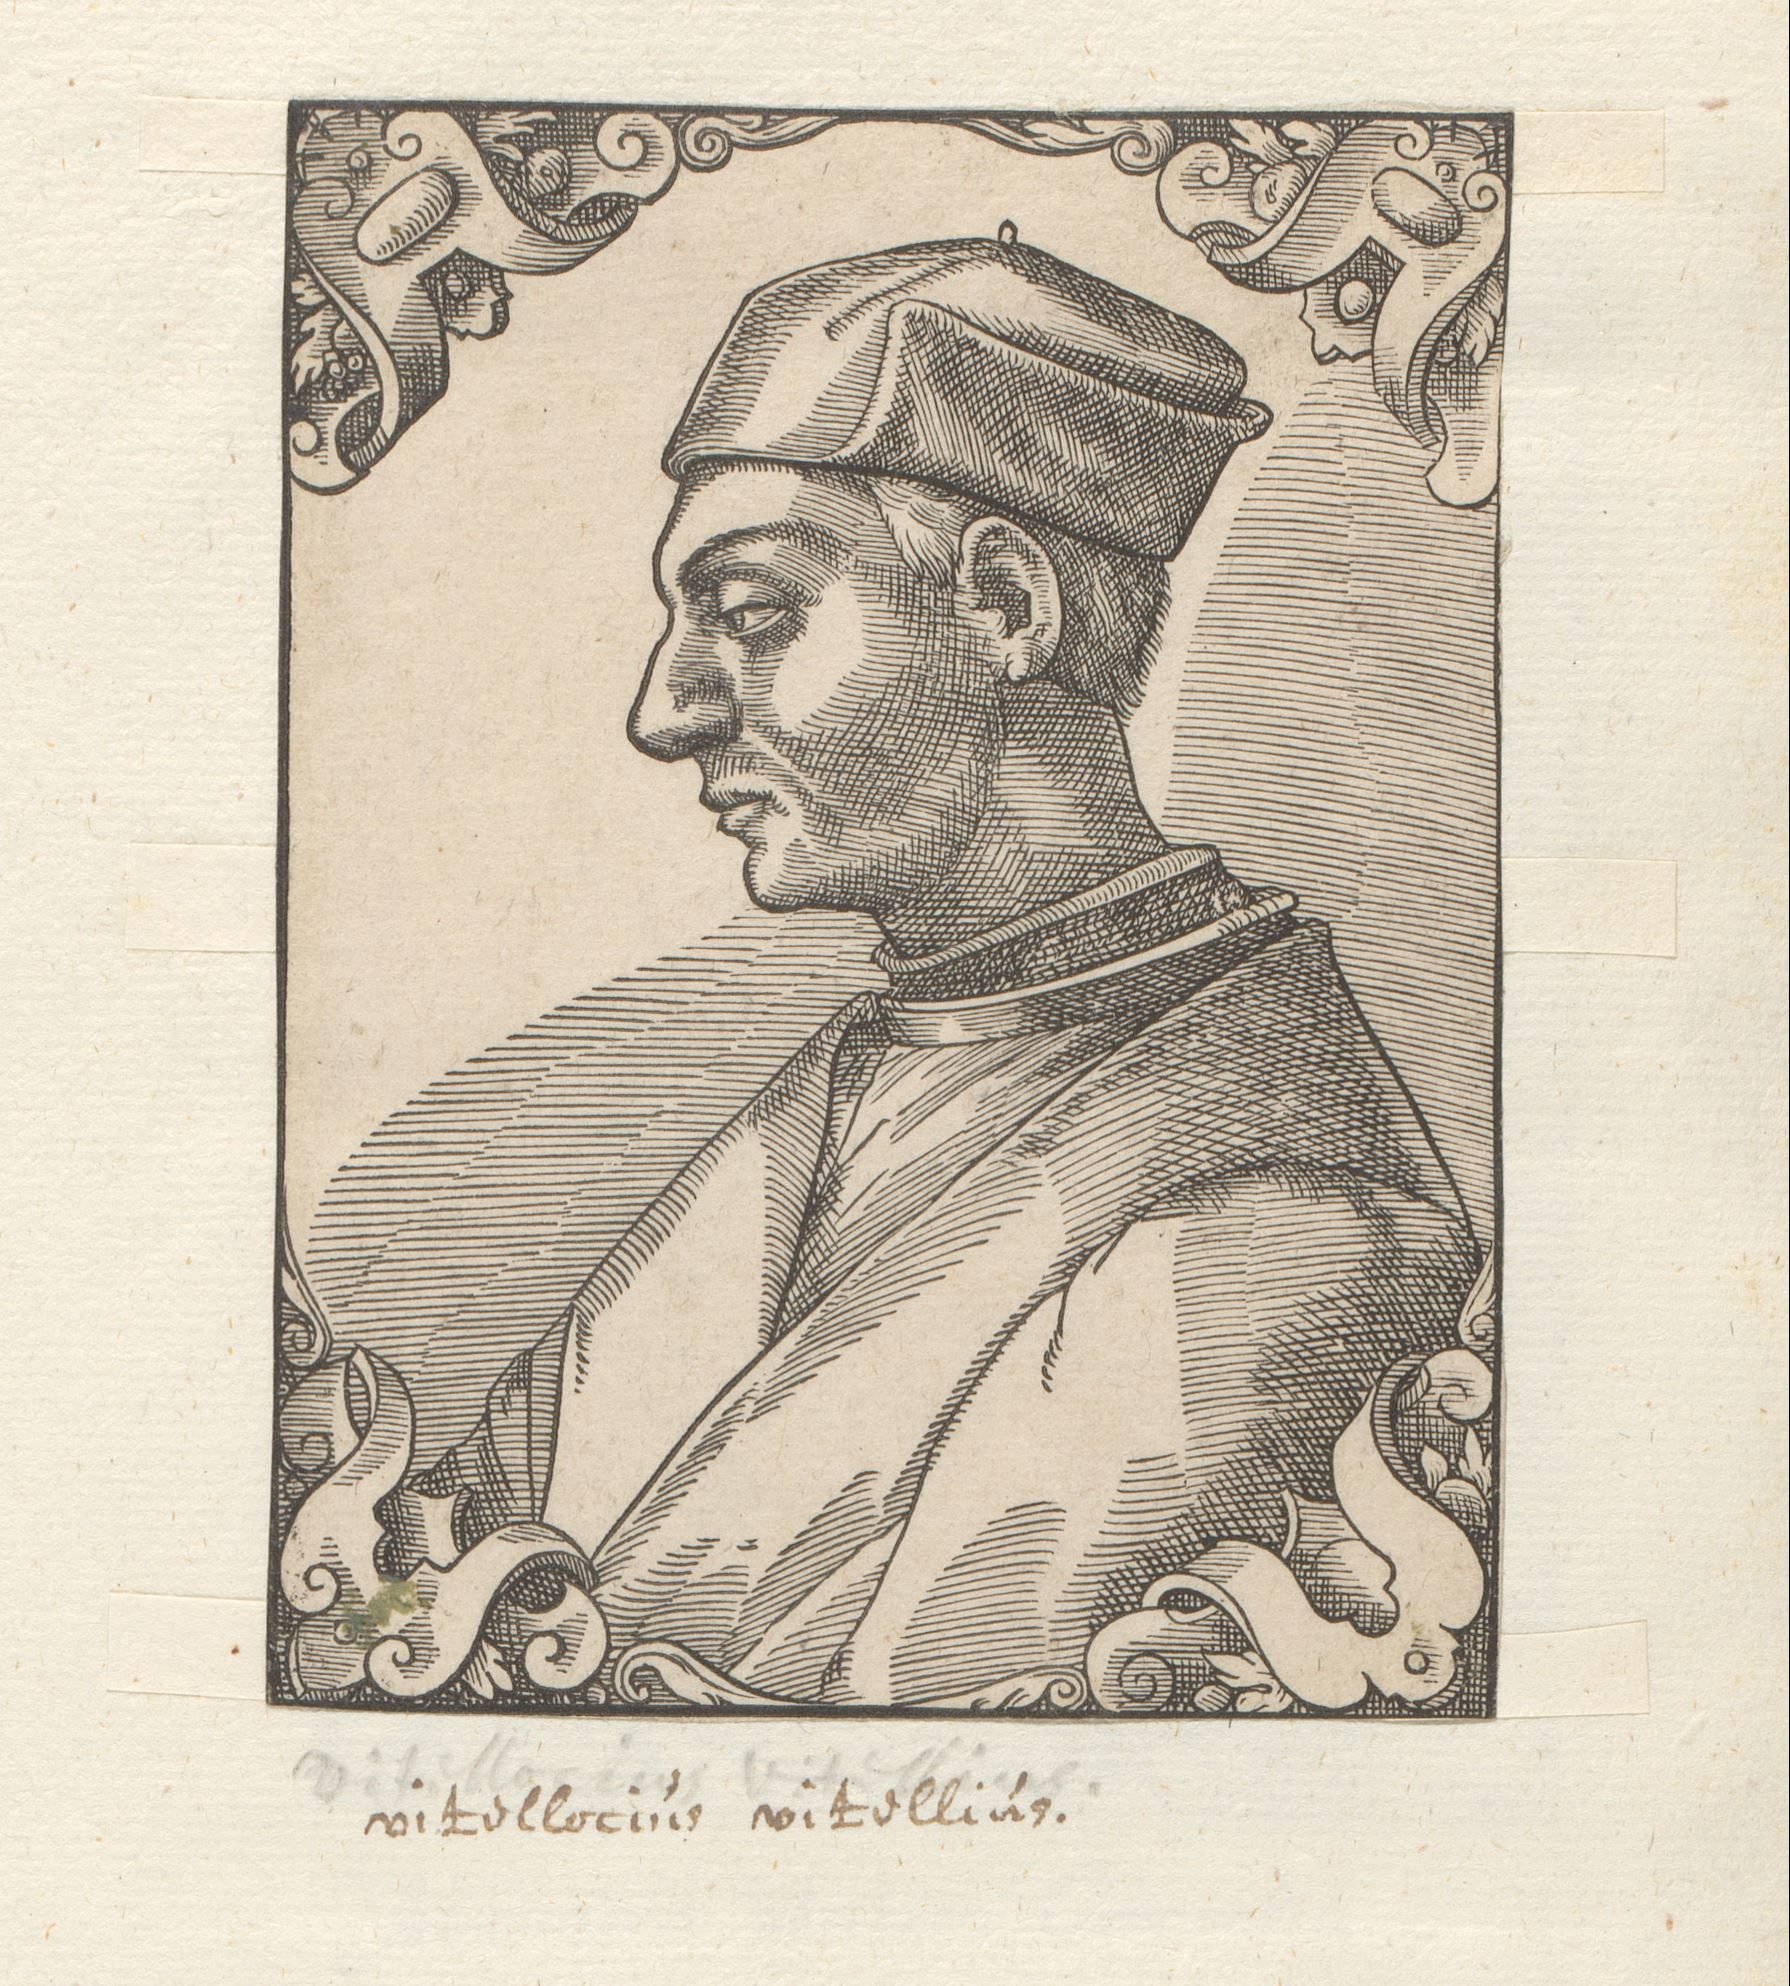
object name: album leaf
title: Portret van Vitellocius Vitellius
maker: Anonymous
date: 1549-1575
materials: paper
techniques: woodcut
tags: historical persons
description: Prent gebruikt in: Giovio, Paolo. Elogia Virorum bellica virtute illustrium (...). Bazel: Peter Perna, 1575.